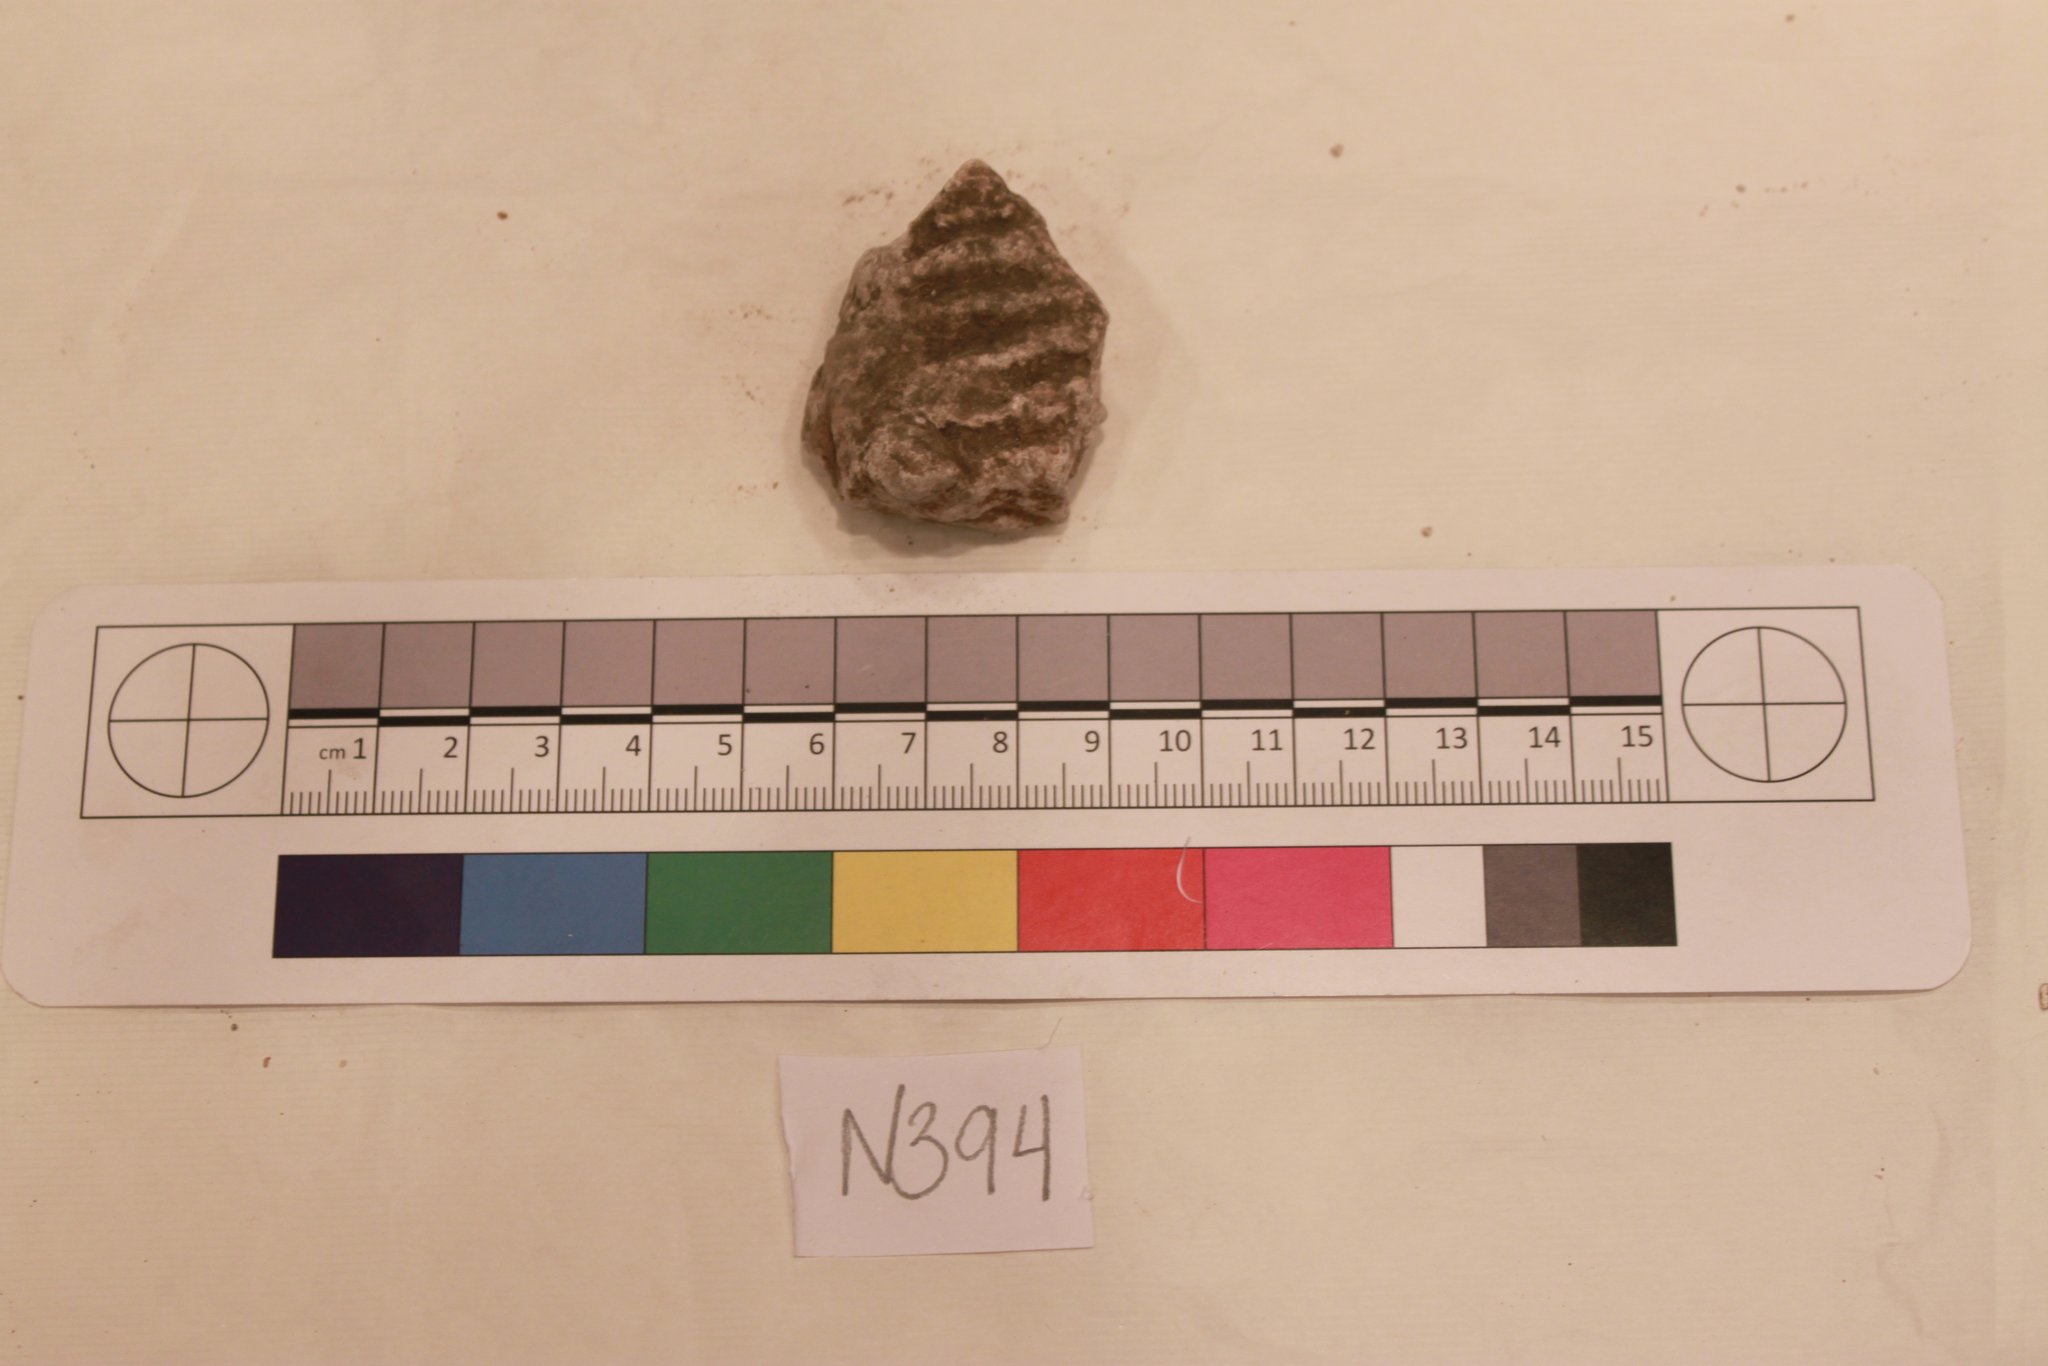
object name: fragment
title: Stucco Fragment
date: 701-1200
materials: plaster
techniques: carving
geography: iran